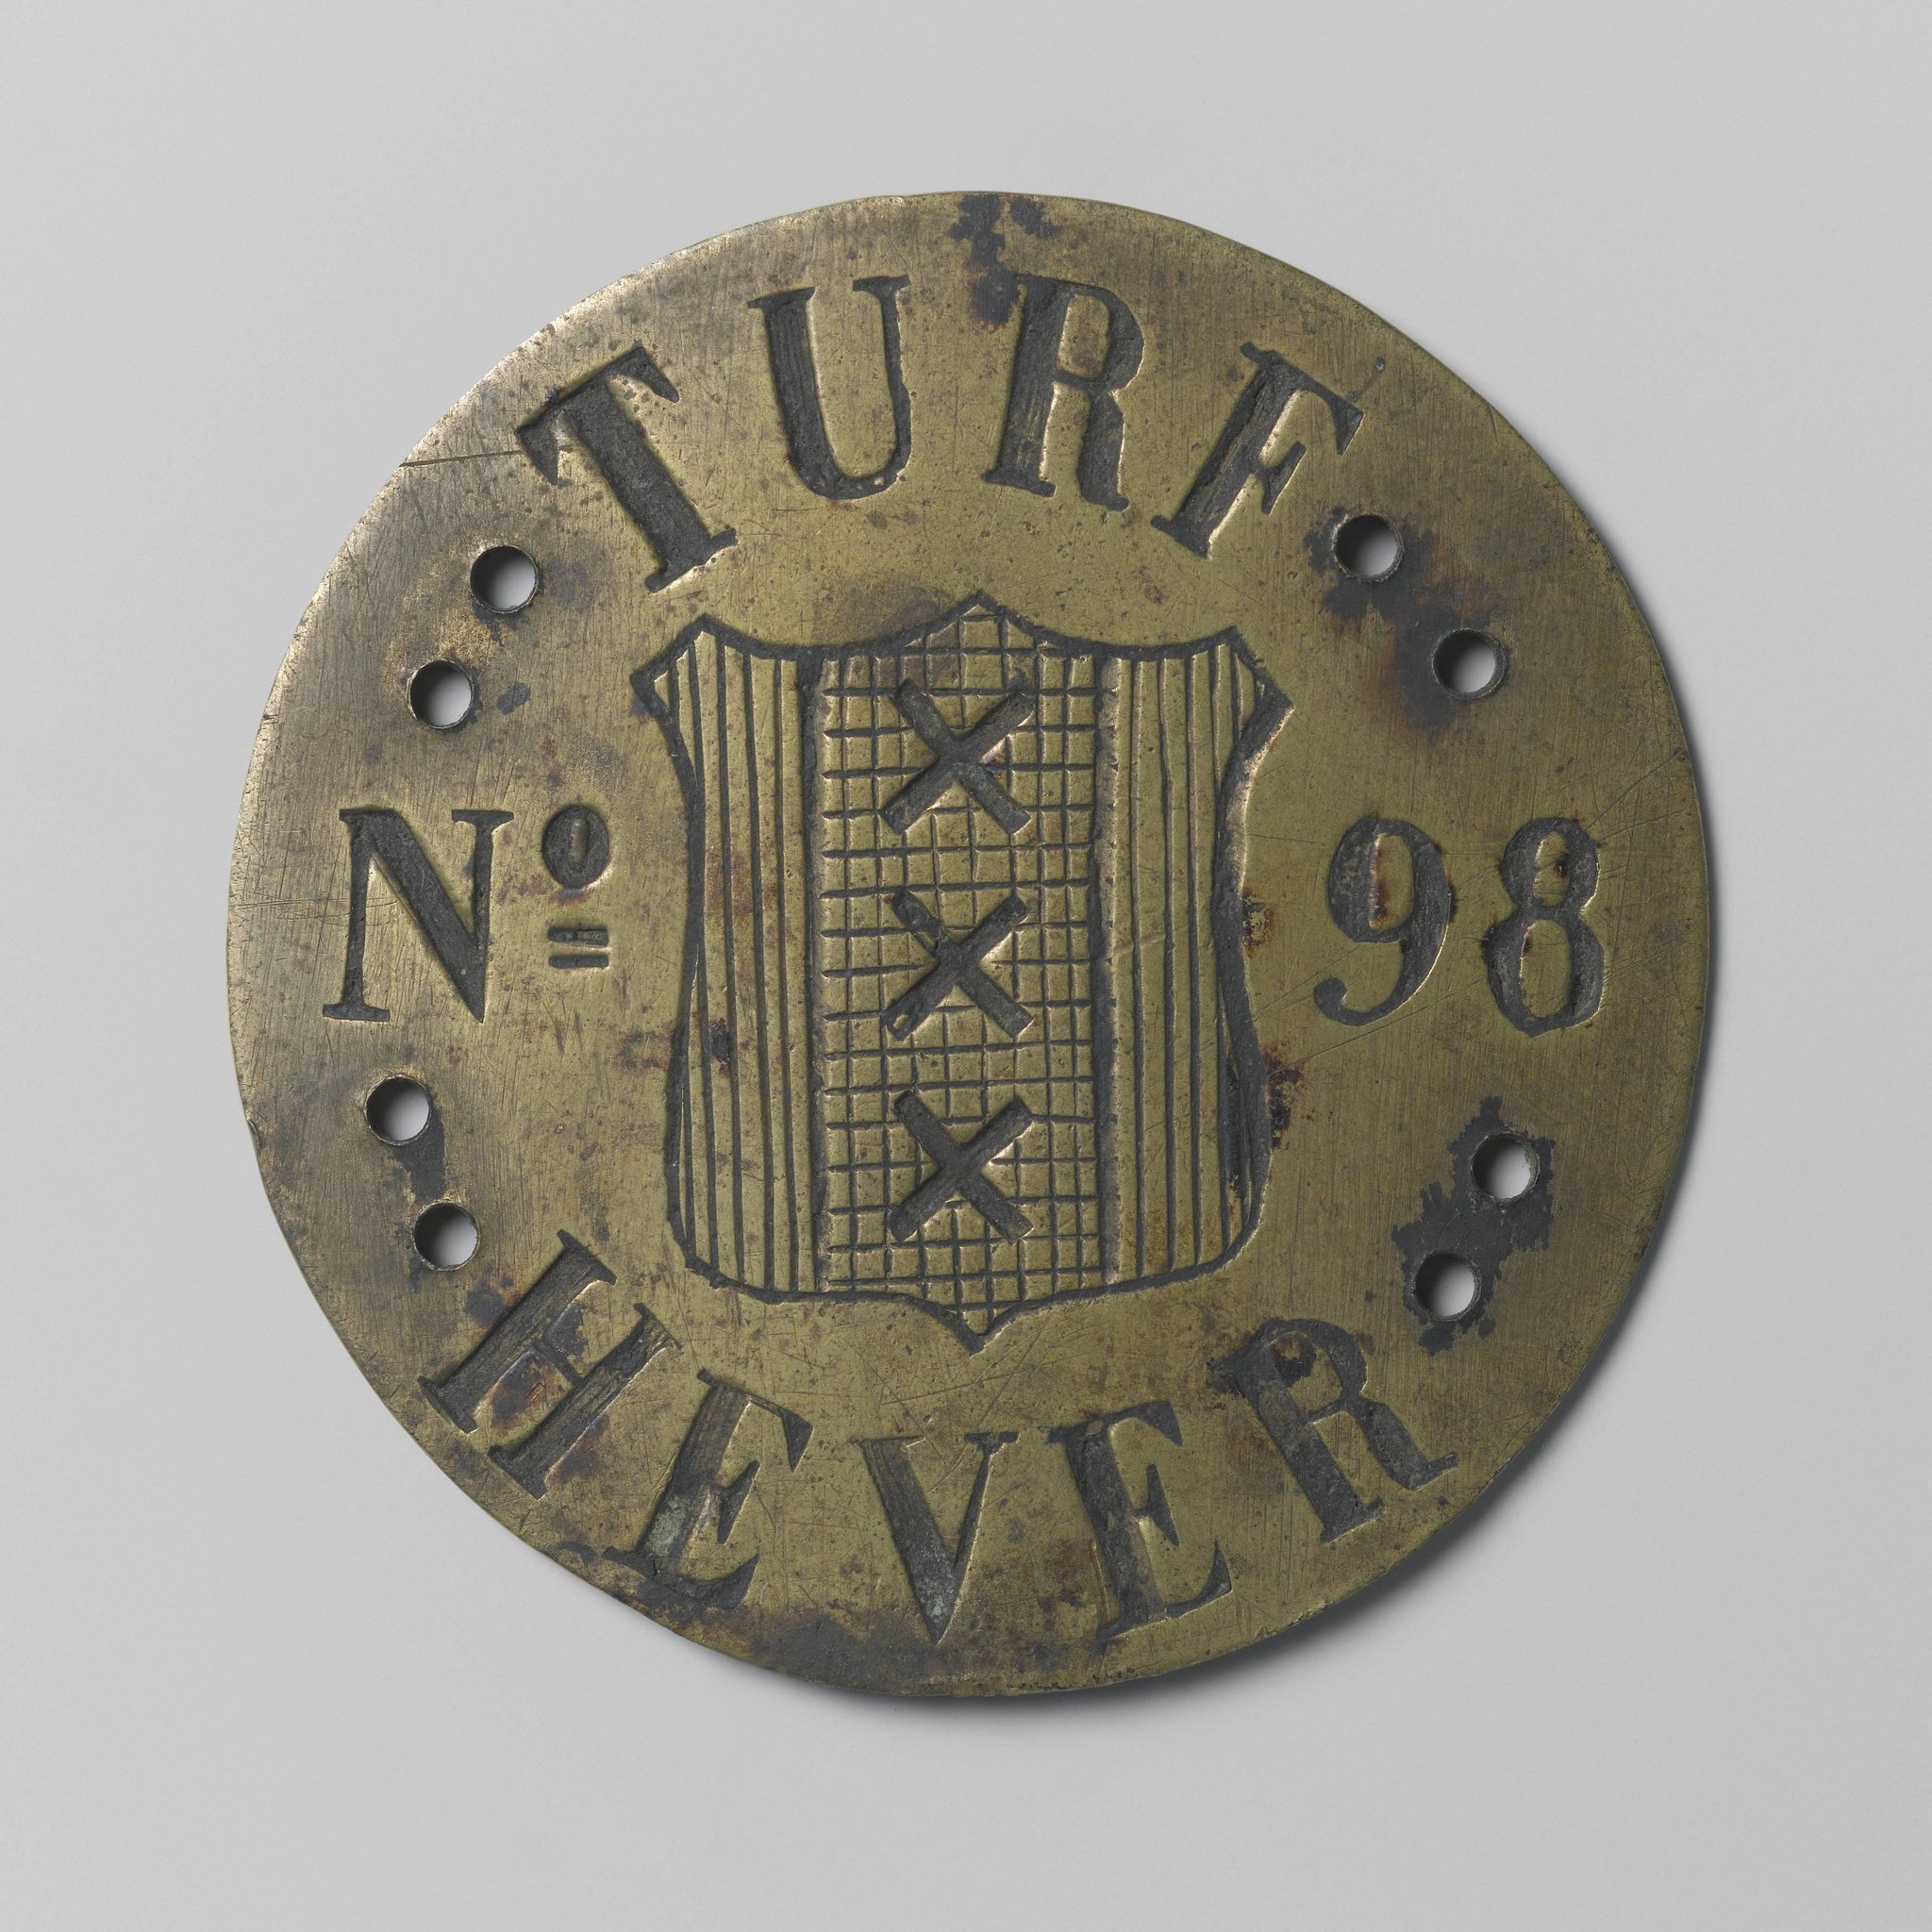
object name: plaque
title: Turfhevers van Amsterdam, plaquette met no. 98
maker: Anonymous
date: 1750-1850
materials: brass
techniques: engraving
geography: amsterdam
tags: amsterdam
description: enigszins bolle, eenzijdige plaquette met aan beide zijkanten, boven- en onderzijde twee gaatjes; v.z: wapenschild tussen opschrift No 98 binnen omschrift. Keerzijde: blanco